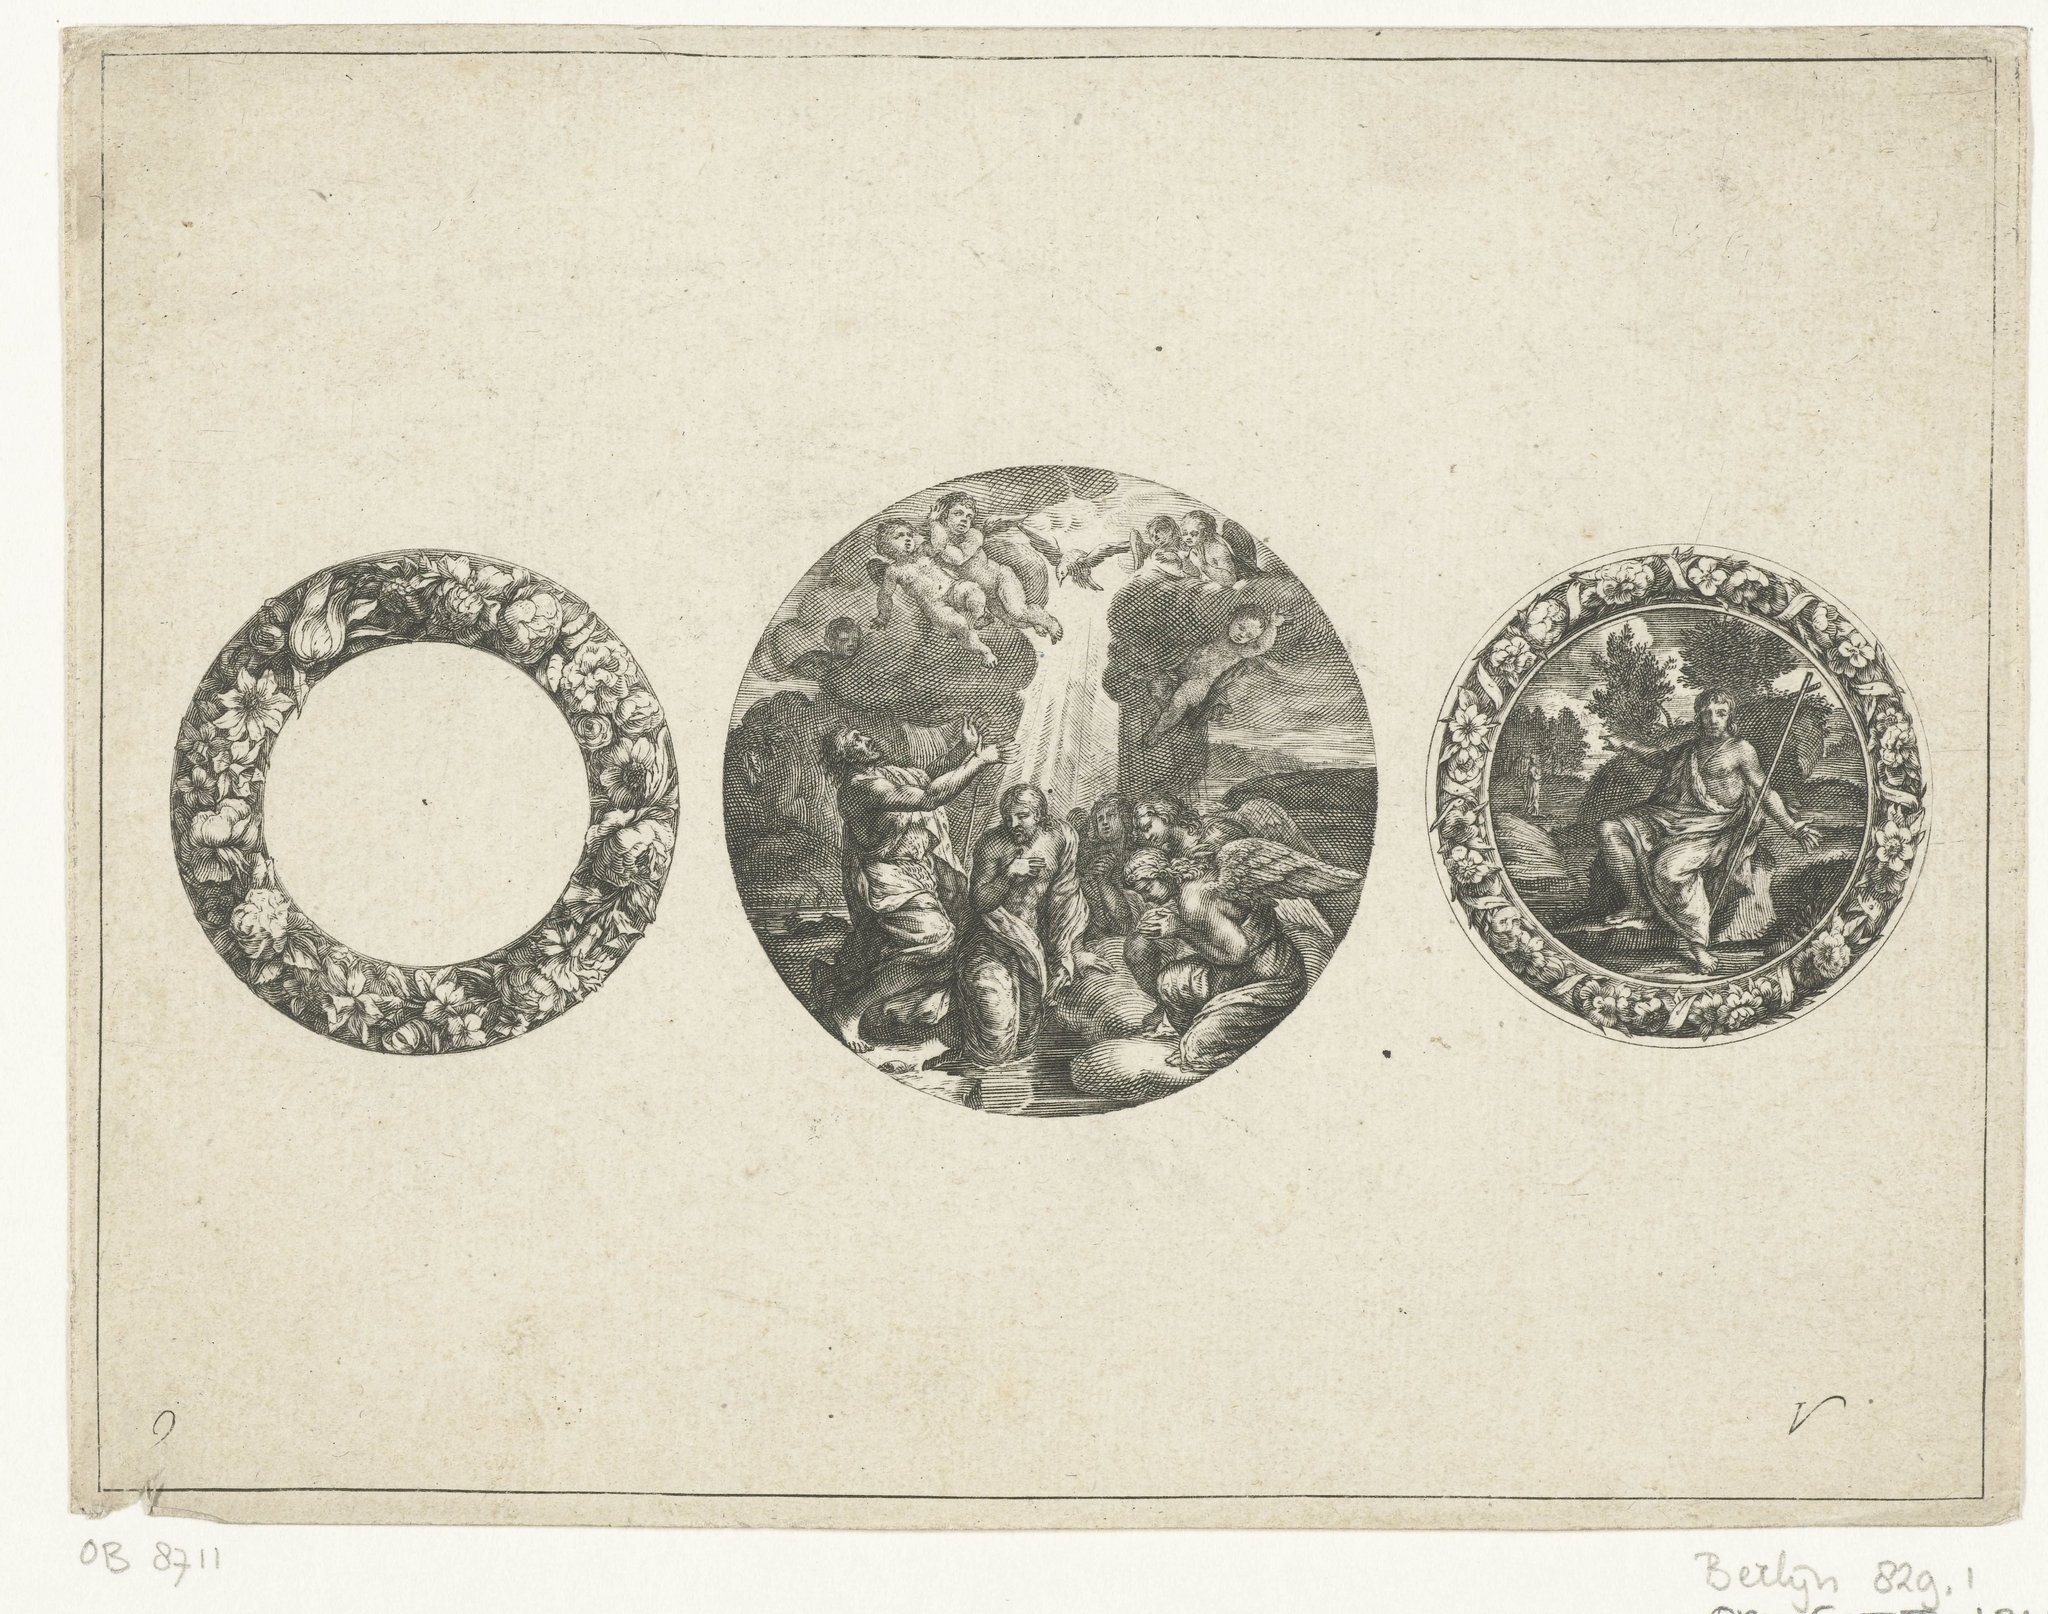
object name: print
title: Bloemenkrans, horlogekast en medaillon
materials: paper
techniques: engraving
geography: france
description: In het midden een horlogekast met de Doop van Christus, rechts een medaillon met Johannes de Doper omringd door een rand van bloemen. Eerste editie, derde druk.